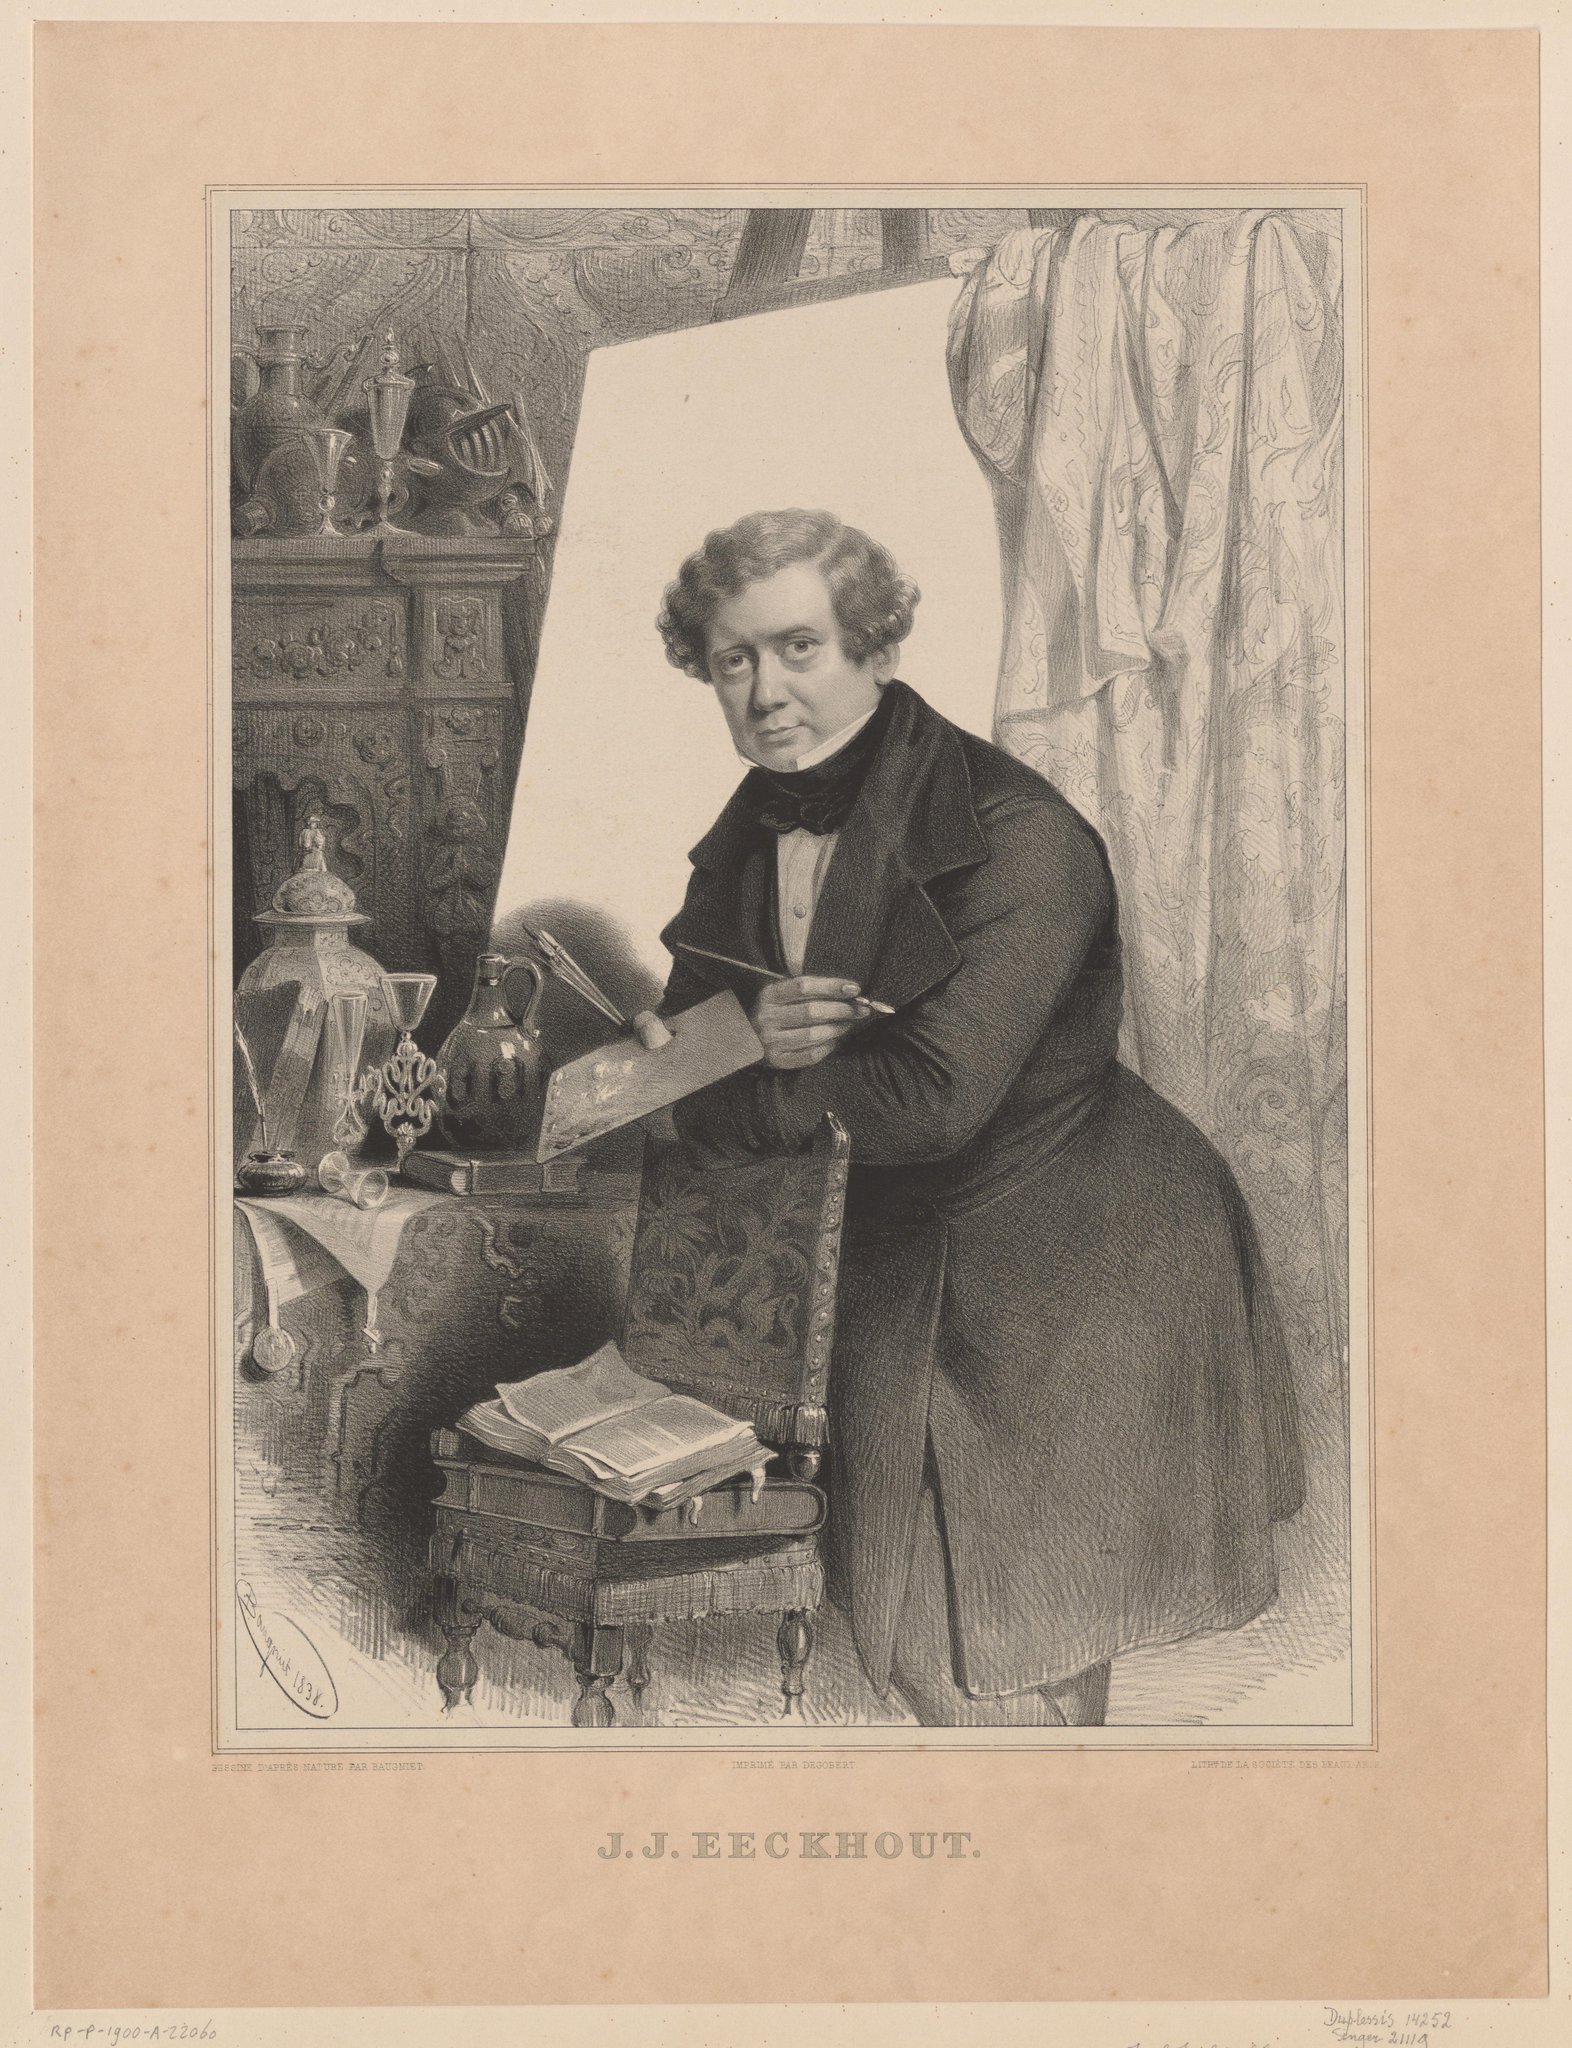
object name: print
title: Portret van Jacob Joseph Eeckhout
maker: charles baugniet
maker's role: print maker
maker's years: 1814-1886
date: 1838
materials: paper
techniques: lithograph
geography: brussels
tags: antwerp, paris, print maker, draughtsman, jacob joseph eeckhout, historical persons, portrait, self-portrait of painter, tools, implements of painter, book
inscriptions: collector's mark: Lugt 2228